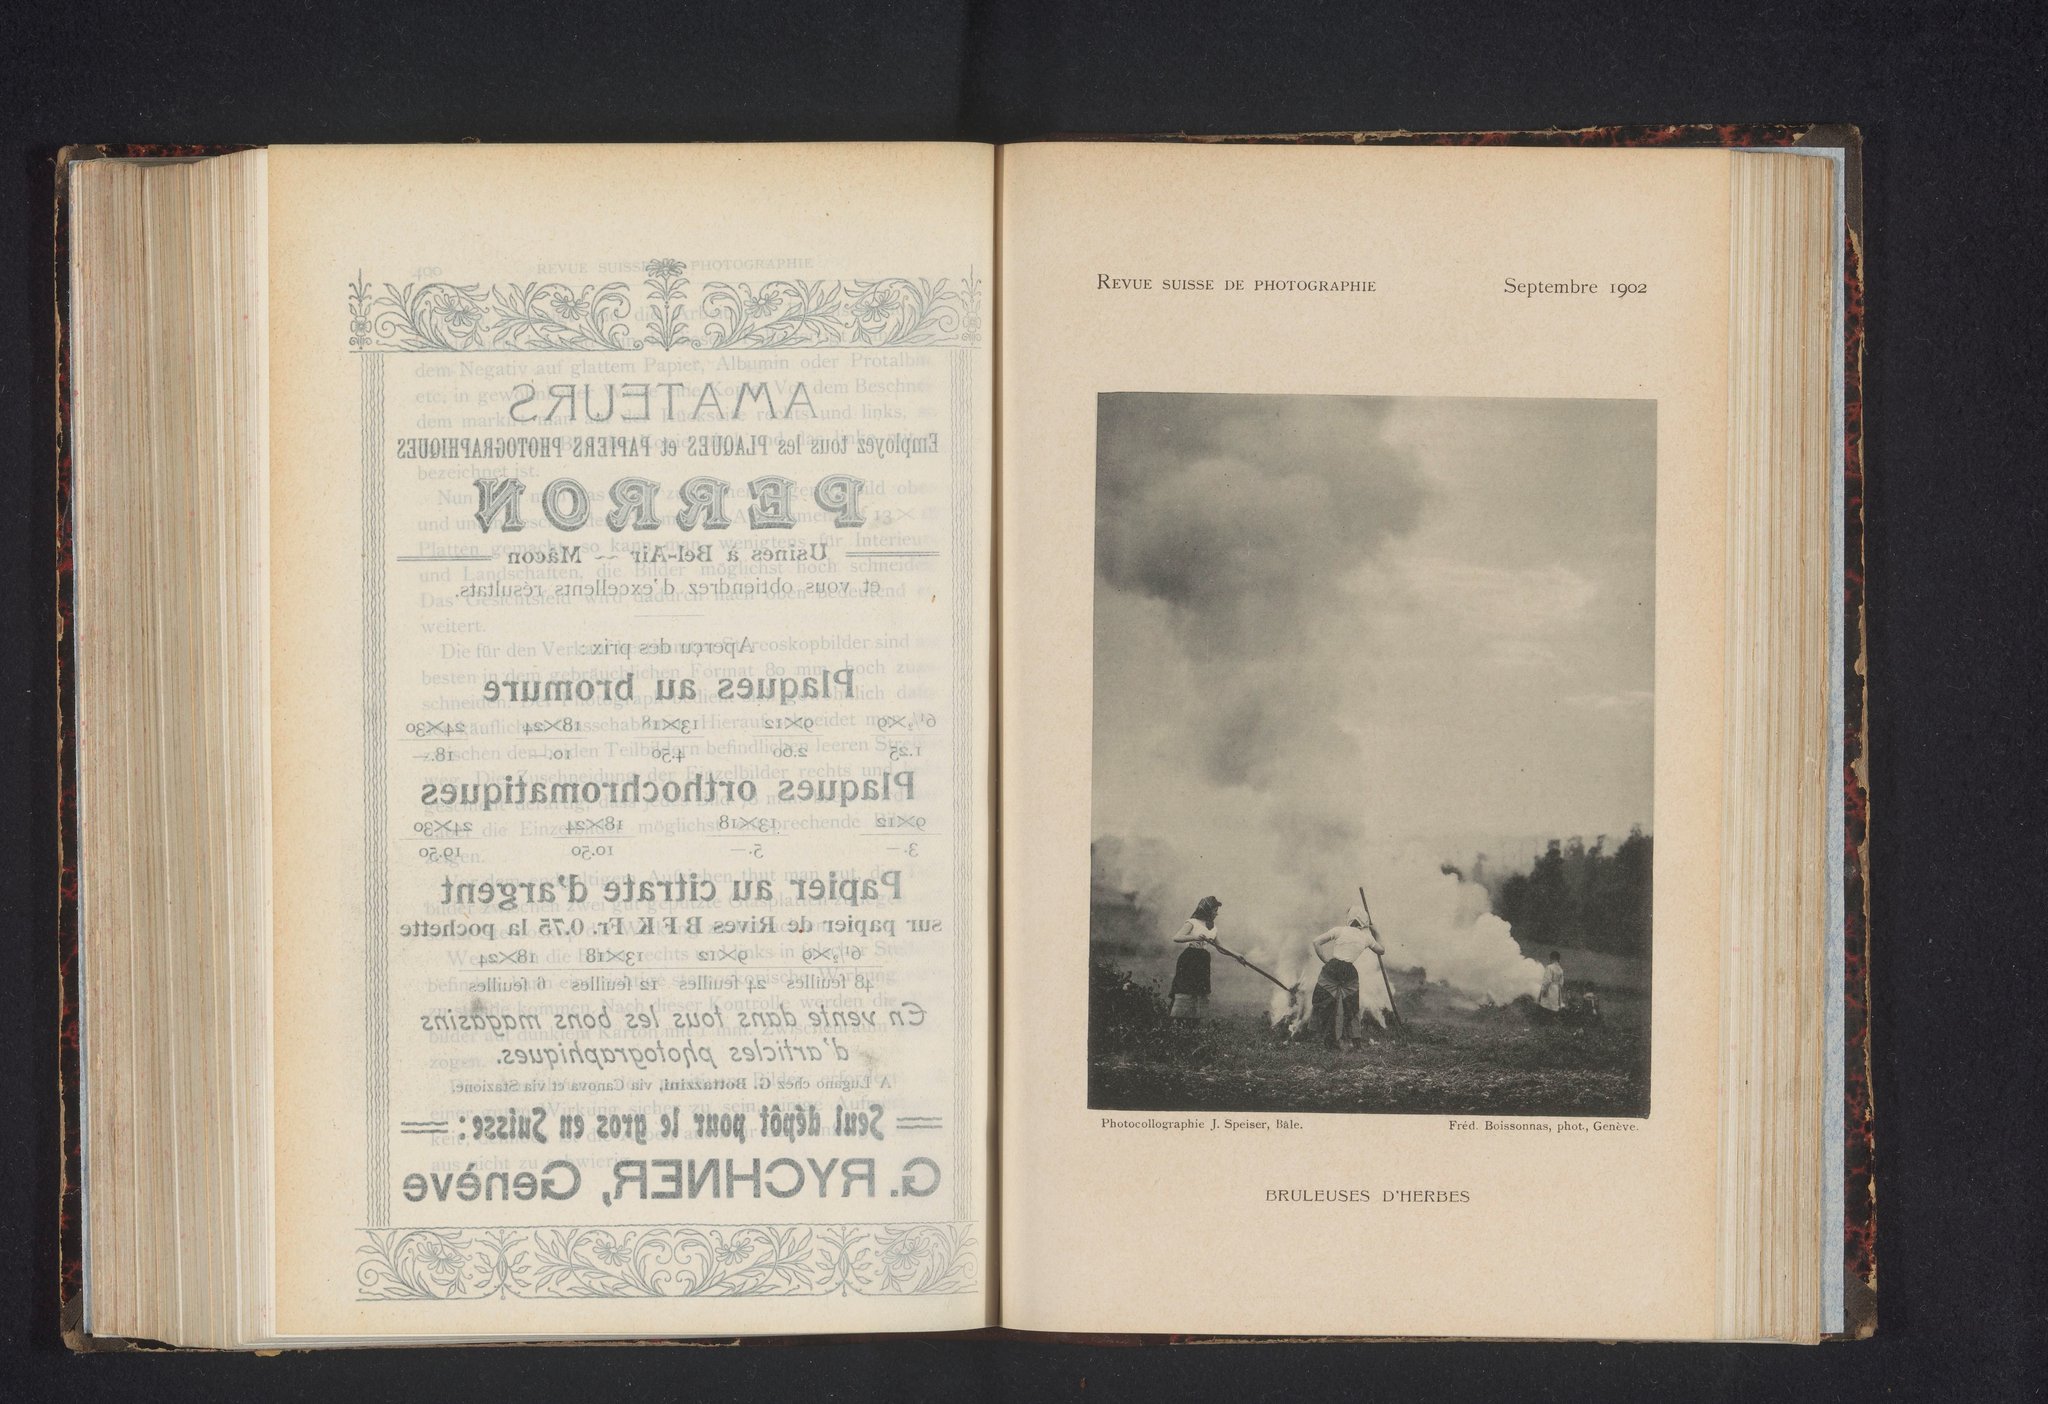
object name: page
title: Bruleuses d'herbes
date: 1897-1902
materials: paper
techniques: photograph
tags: burning, agriculture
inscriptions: inscription: ‘Revue Suisse de photographie/ Septembre 1902’